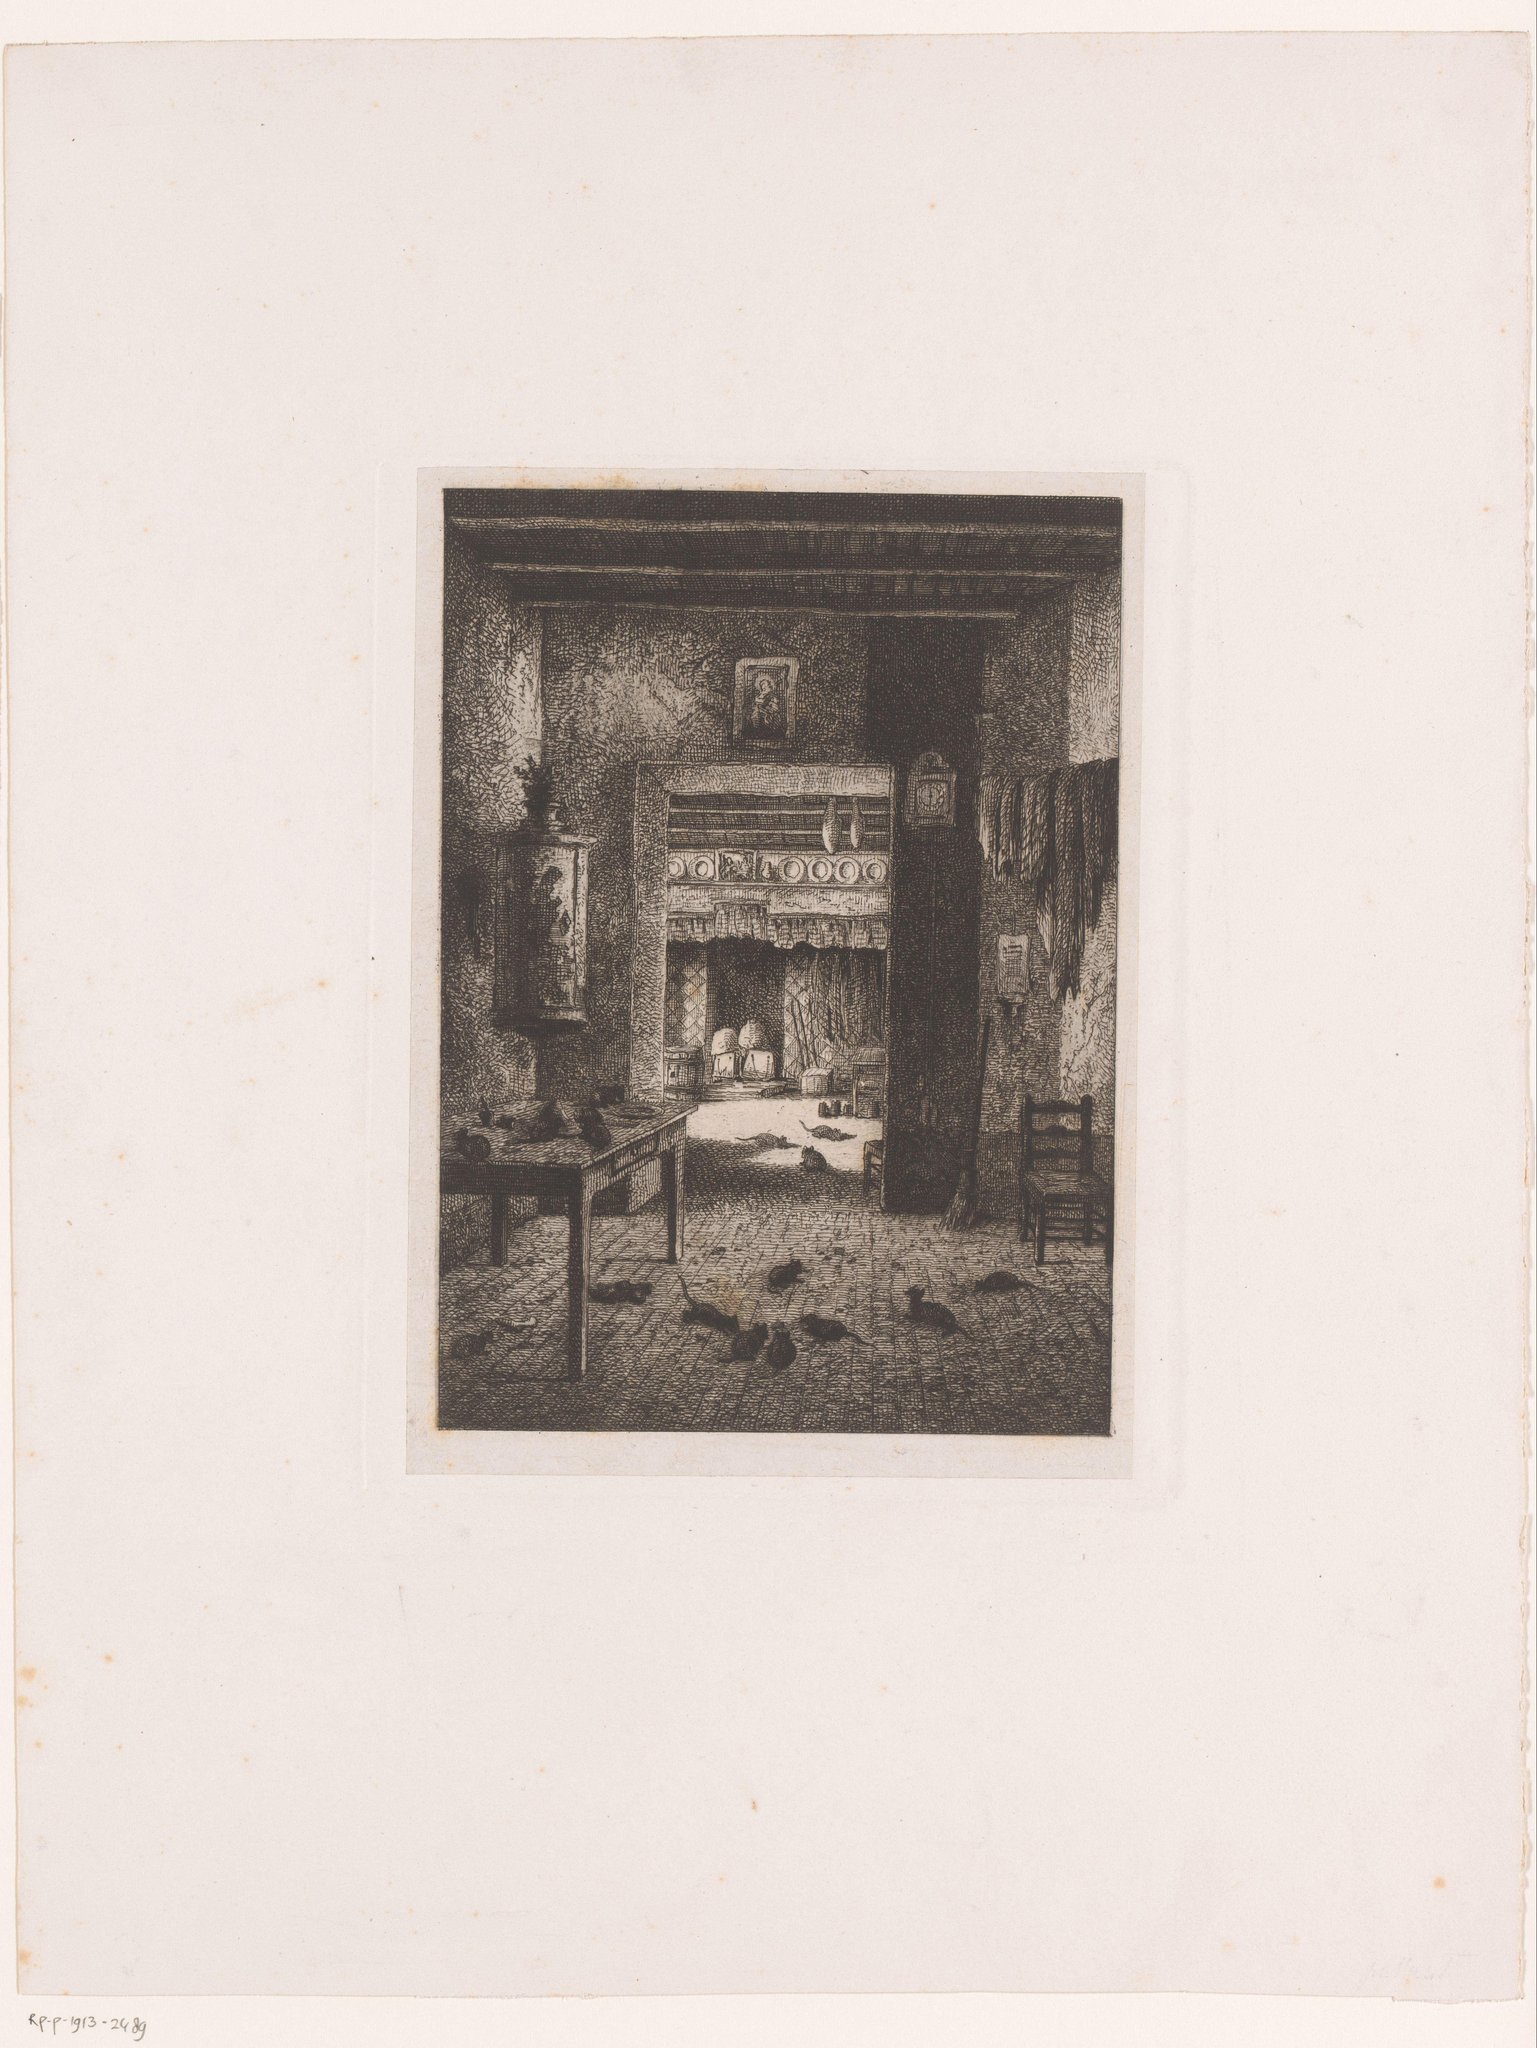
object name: print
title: Muizen in een interieur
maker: emile puttaert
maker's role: print maker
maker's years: 1829-1901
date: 1874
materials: paper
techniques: drypoint, etching, intaglio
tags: rodents: mouse, interior ~ representation of a building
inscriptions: collector's mark: Lugt 2228